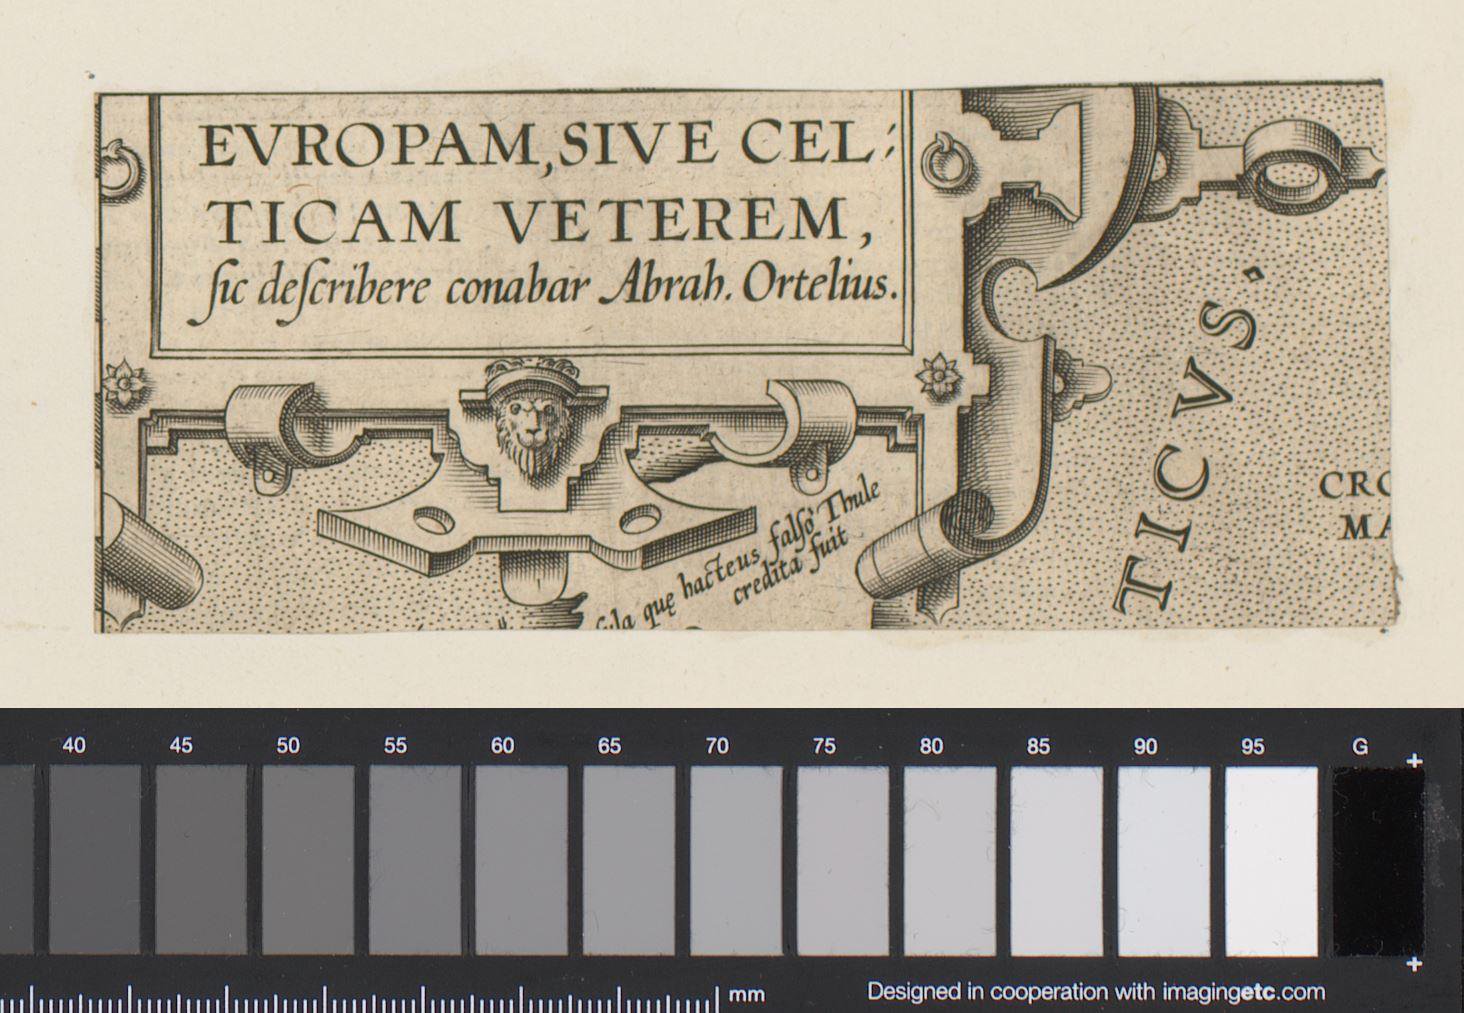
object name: album leaf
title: Theatrum Orbis Terrarum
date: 1595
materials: paper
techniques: engraving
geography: antwerp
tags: scrollwork, strapwork ~ ornament, ornament ~ cartouche, mask, mascaron ~ ornament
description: De cartouche is gekopieerd naar een prent van een anonieme graveur naar het ontwerp van Hans Vredeman de Vries, onderdeel van een serie van rolwerkcartouches met grotesken uit circa 1555-1560.